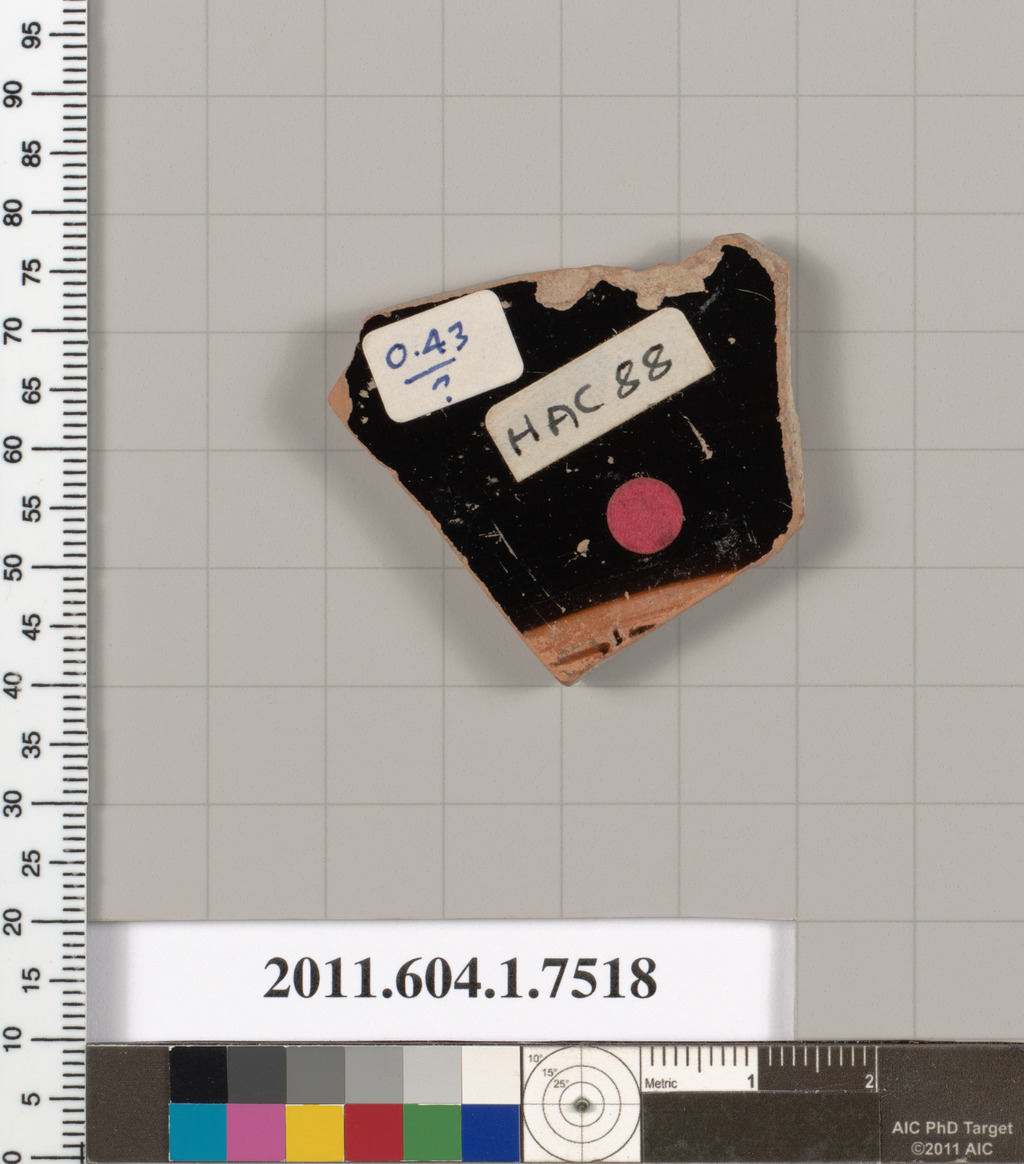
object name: kylix fragment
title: Terracotta fragment of a kylix (drinking cup)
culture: greek, attic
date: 460-450 BCE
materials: terracotta